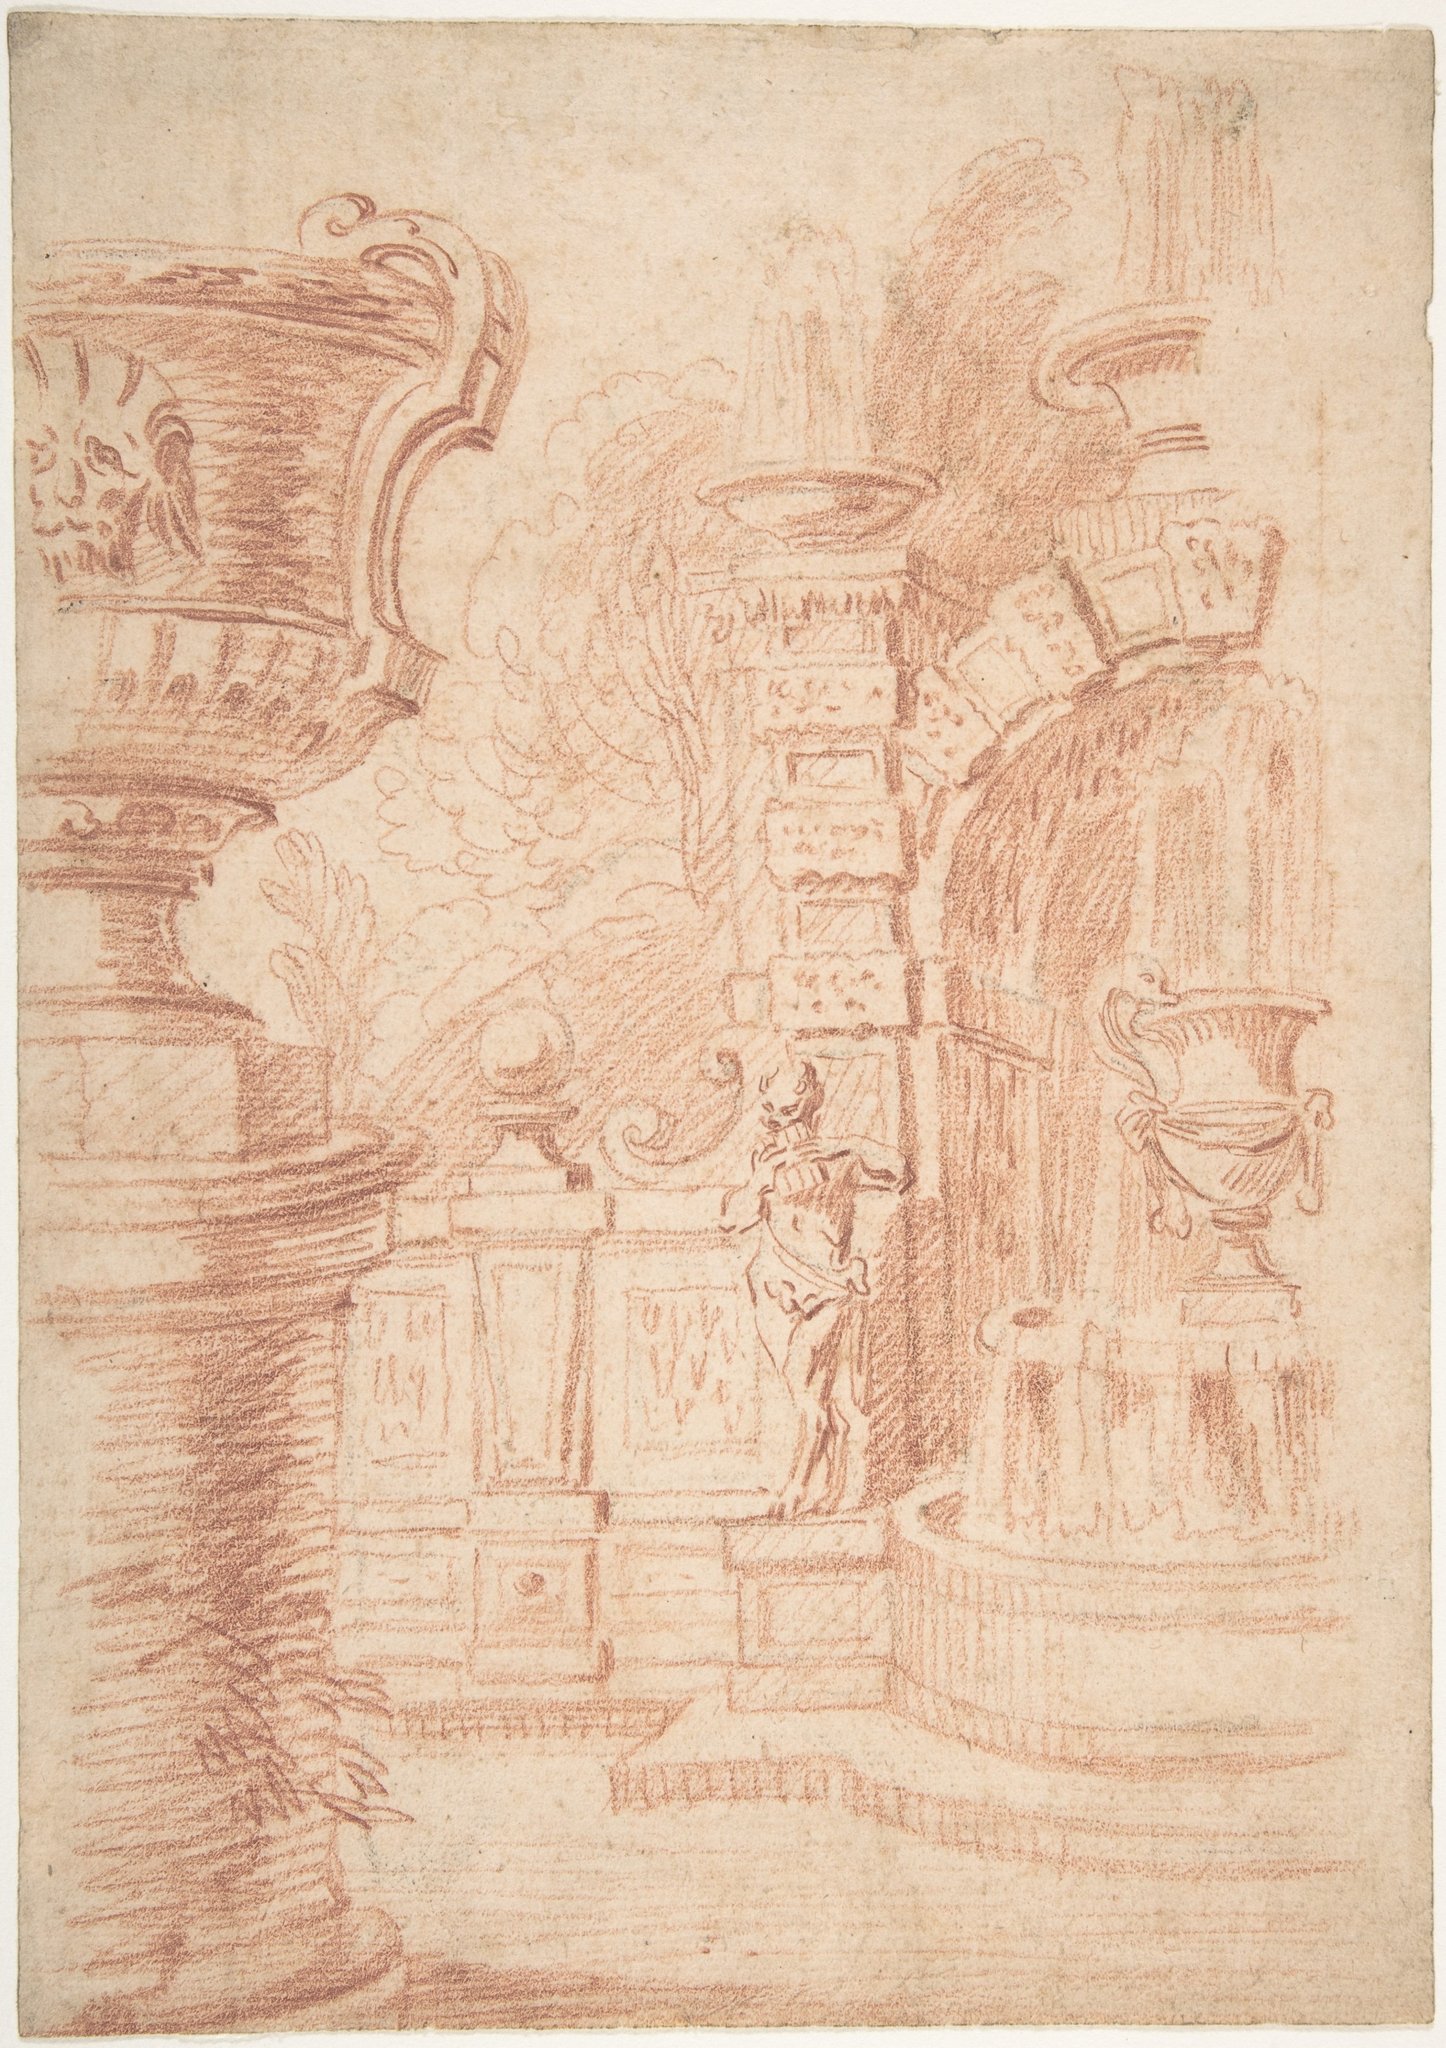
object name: drawing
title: Study for a Garden Capriccio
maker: gilles-marie oppenord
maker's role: artist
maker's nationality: french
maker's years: 1672-1742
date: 1672-1742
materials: chalk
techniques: drawing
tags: human figures,architecture,buildings,fauns